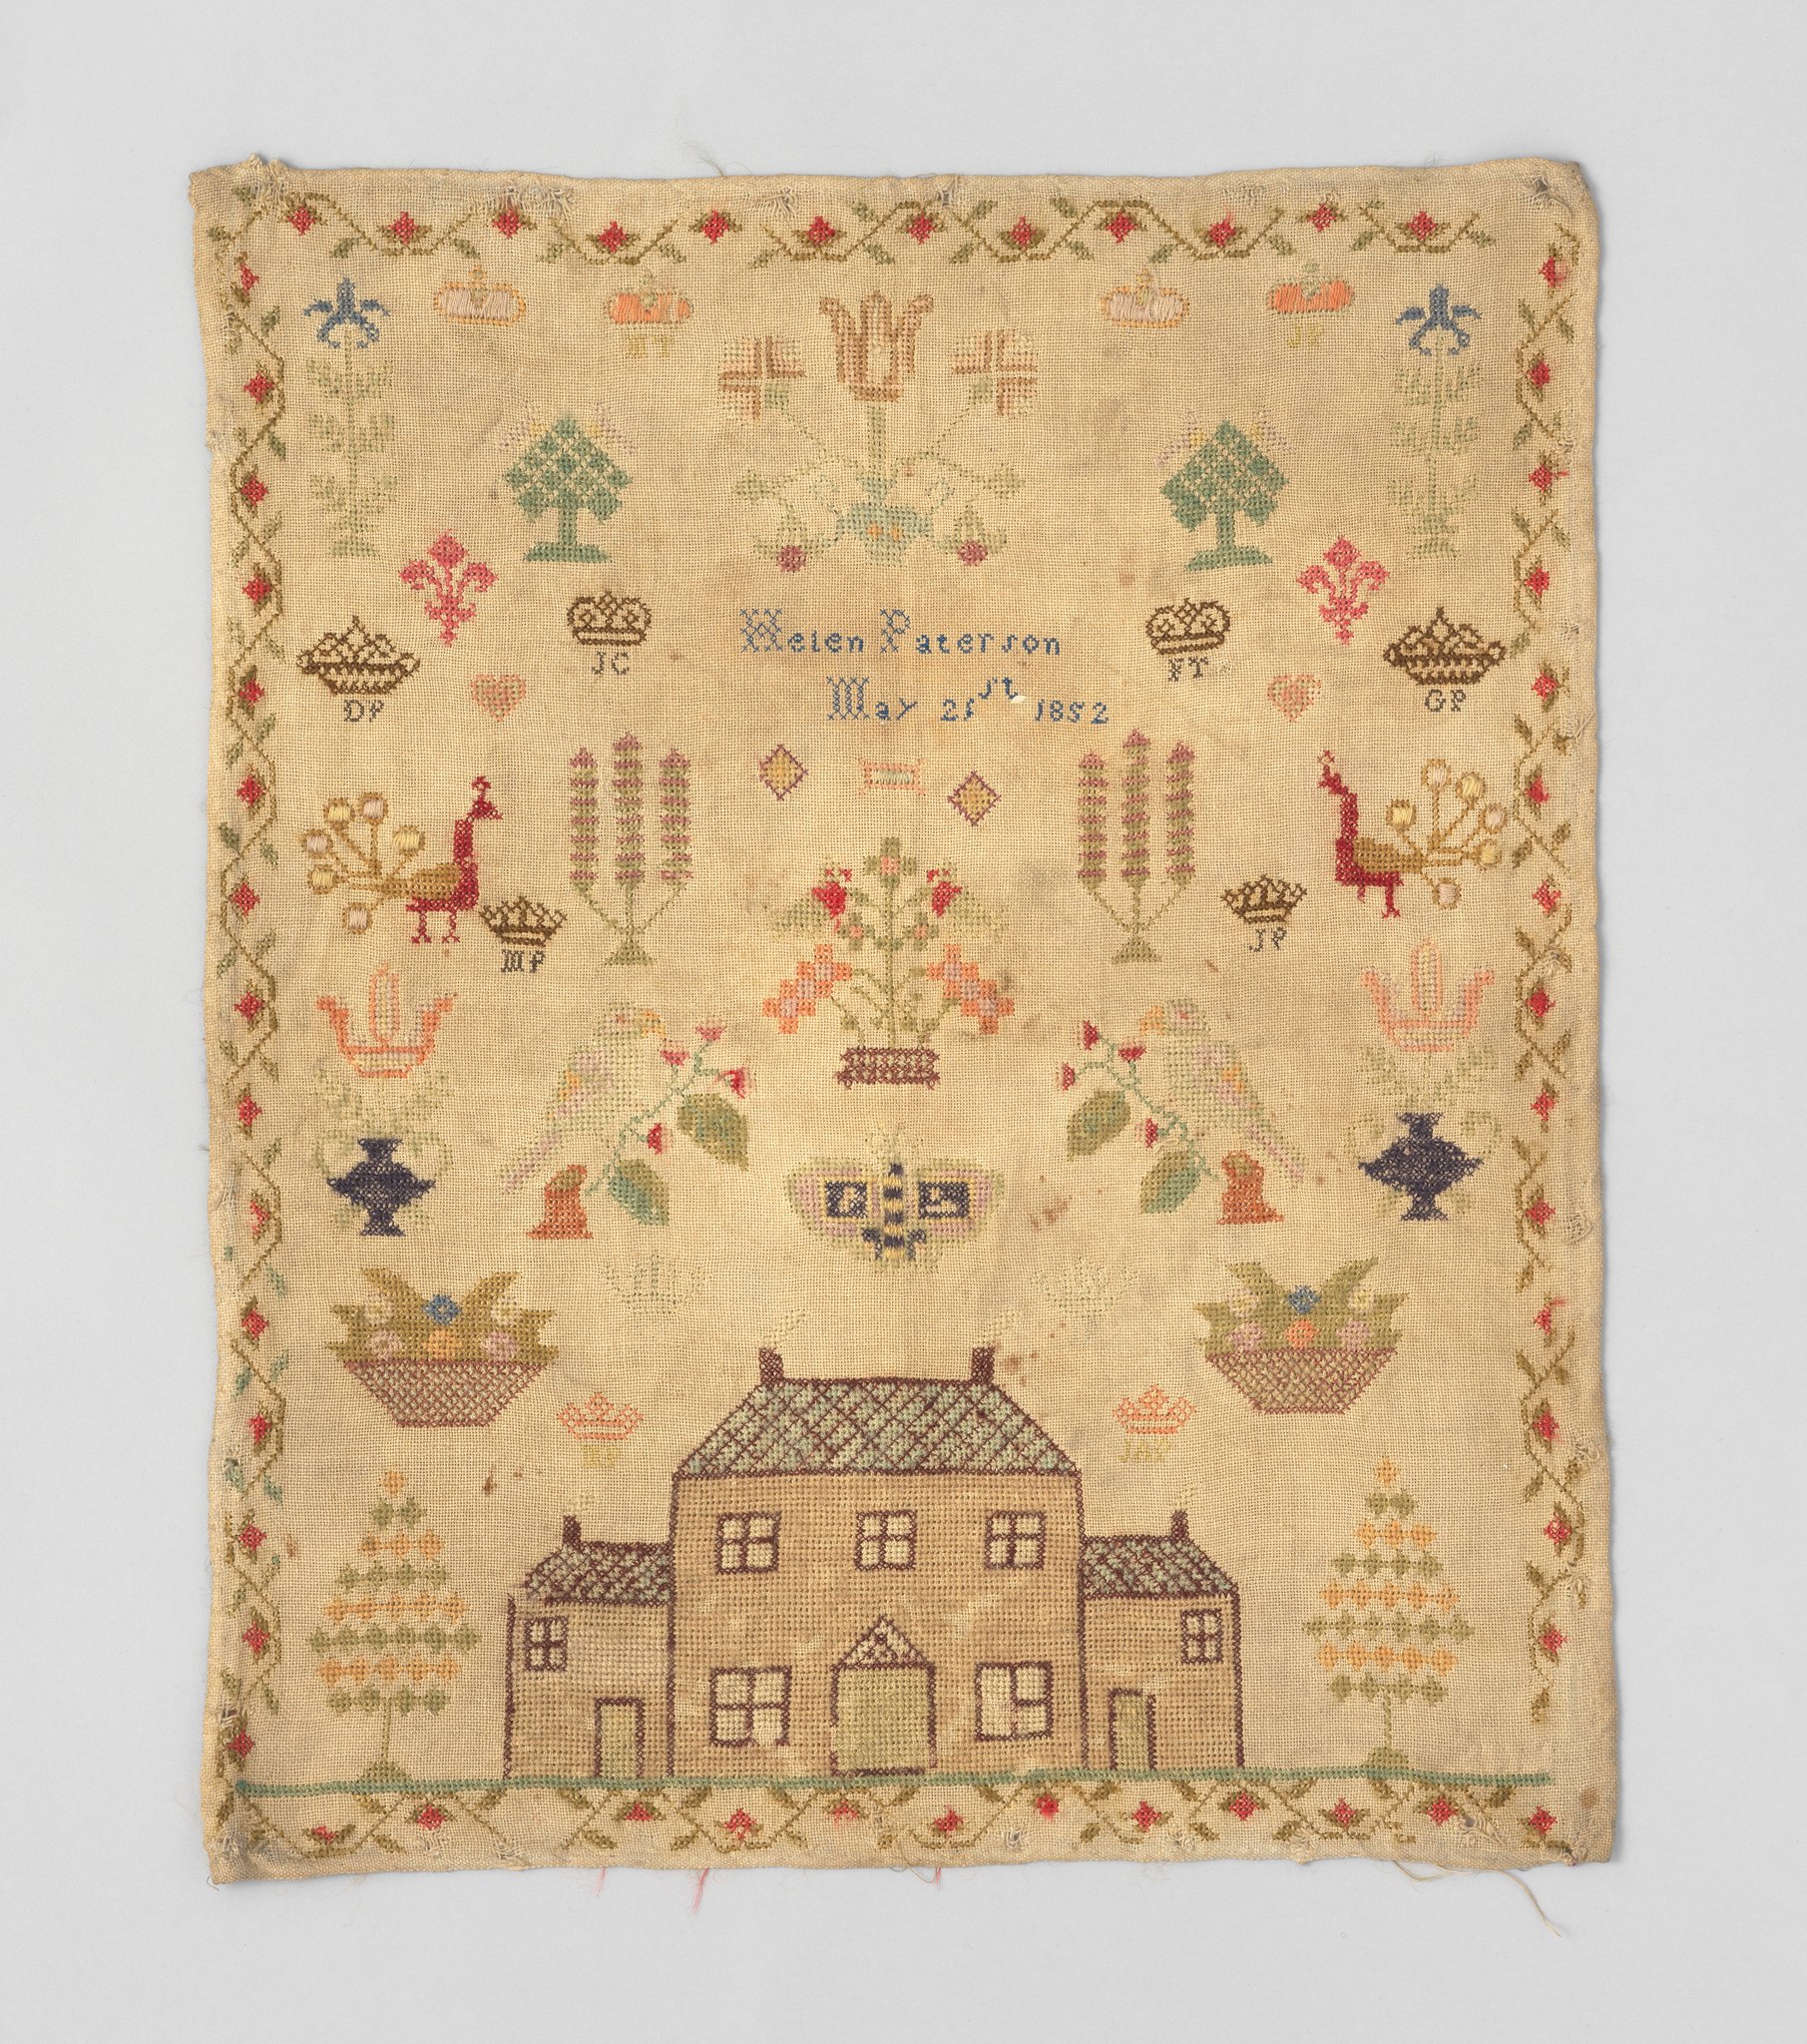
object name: sampler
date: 1852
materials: canvas, cotton, silk, wool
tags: houses,peacocks,trees